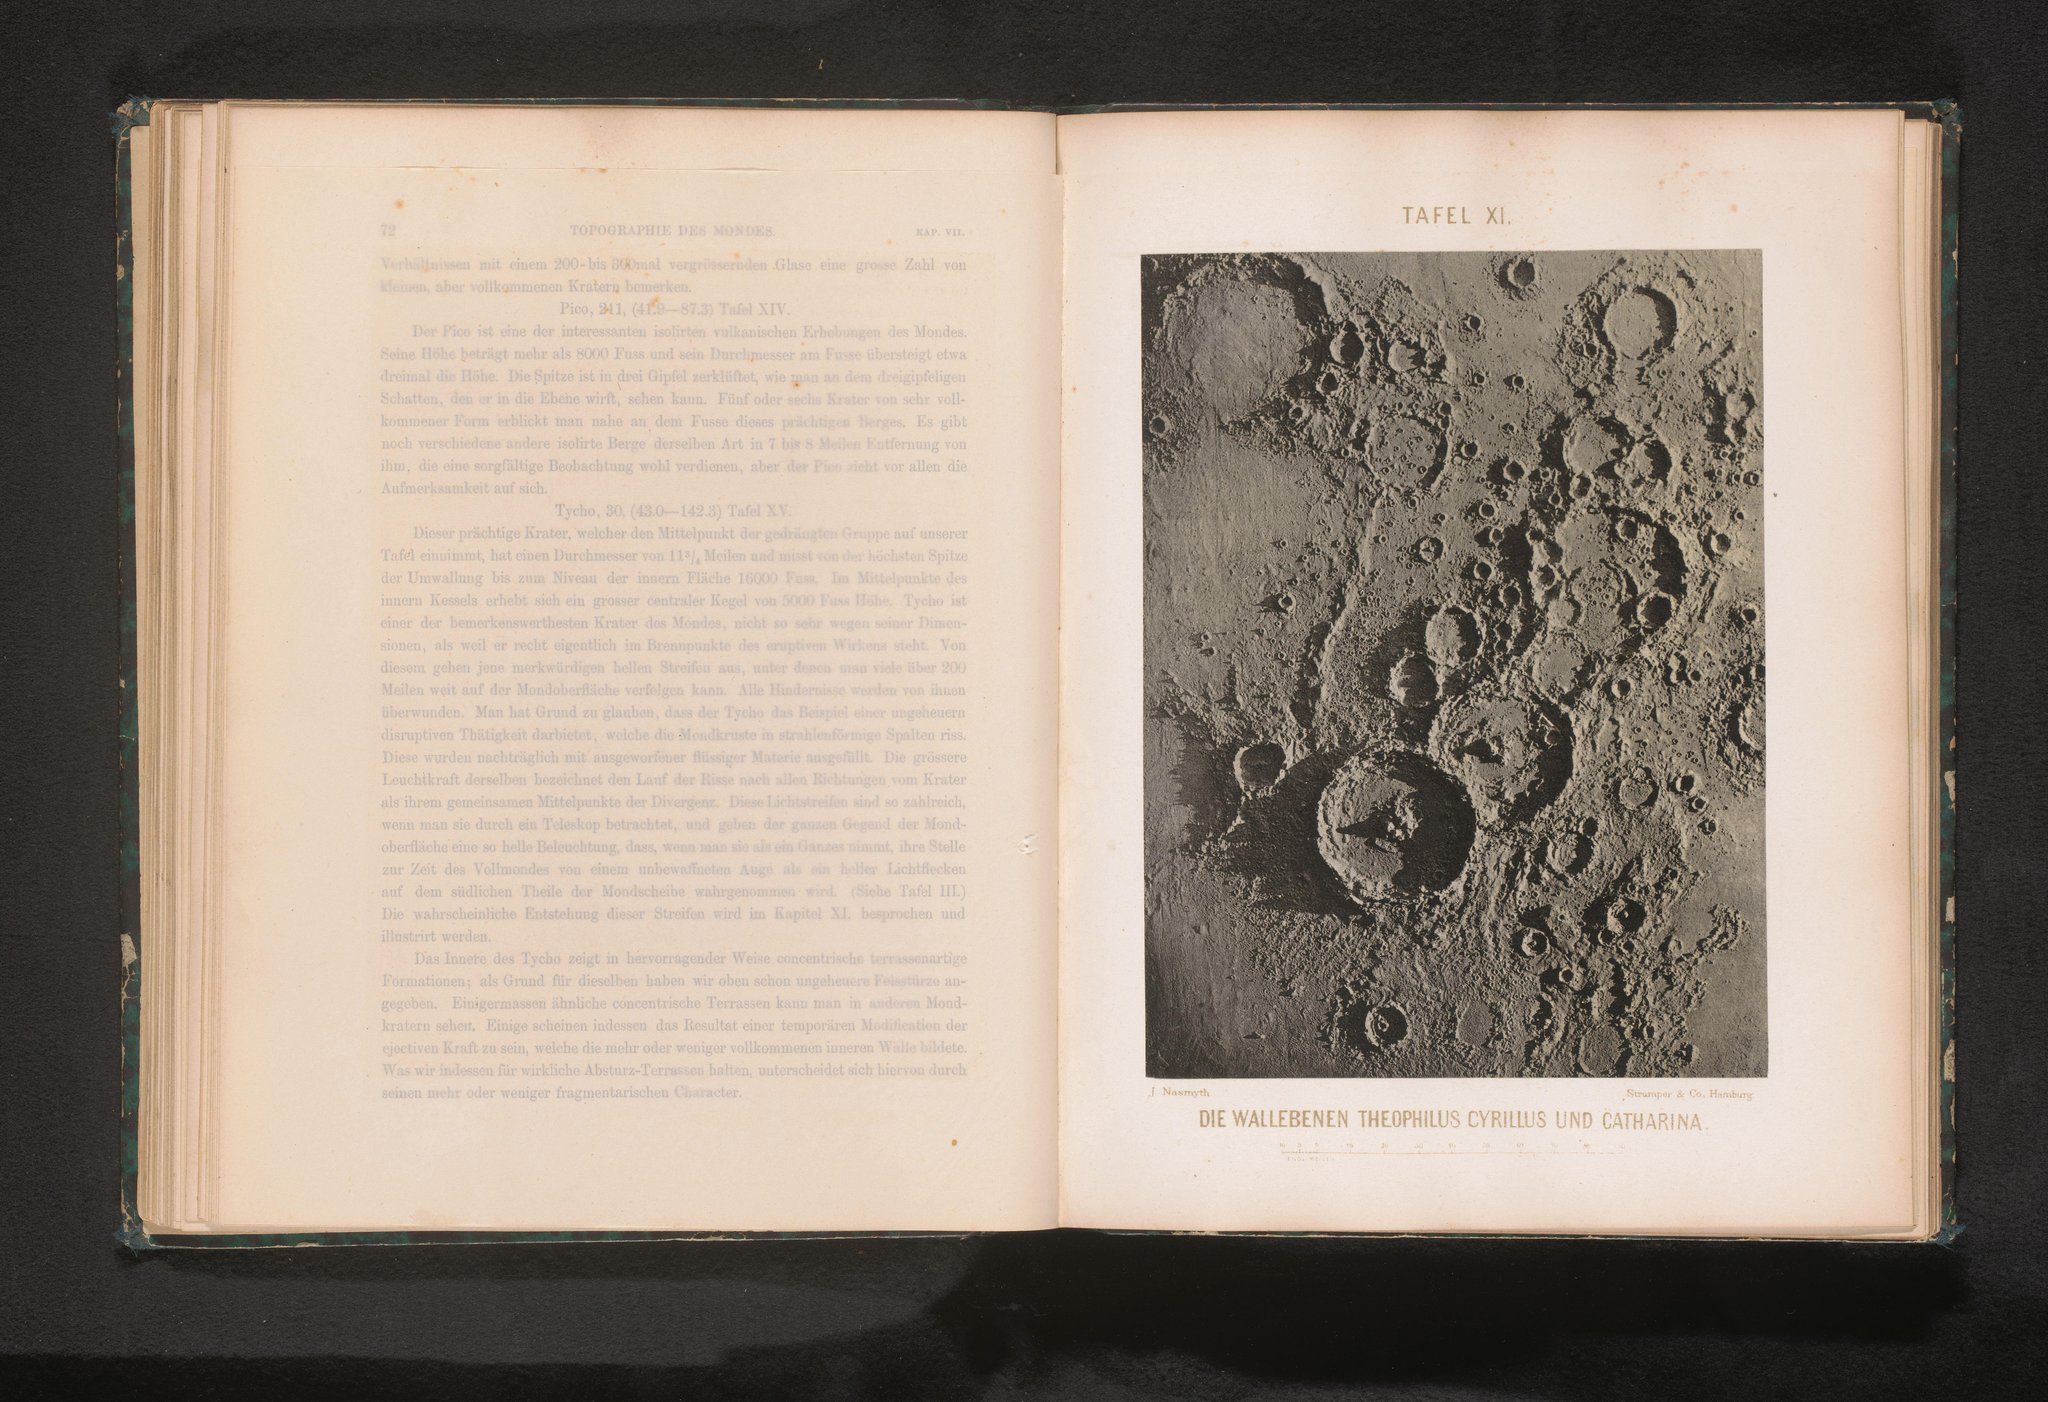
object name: photomechanical print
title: Die Wallebenen Theophilus Cyrillus und Catharina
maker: james nasmyth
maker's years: 1808-1890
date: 1863-1873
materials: paper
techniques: photograph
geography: hamburg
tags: surface of the moon, moon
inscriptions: number: ‘Tafel XI.’